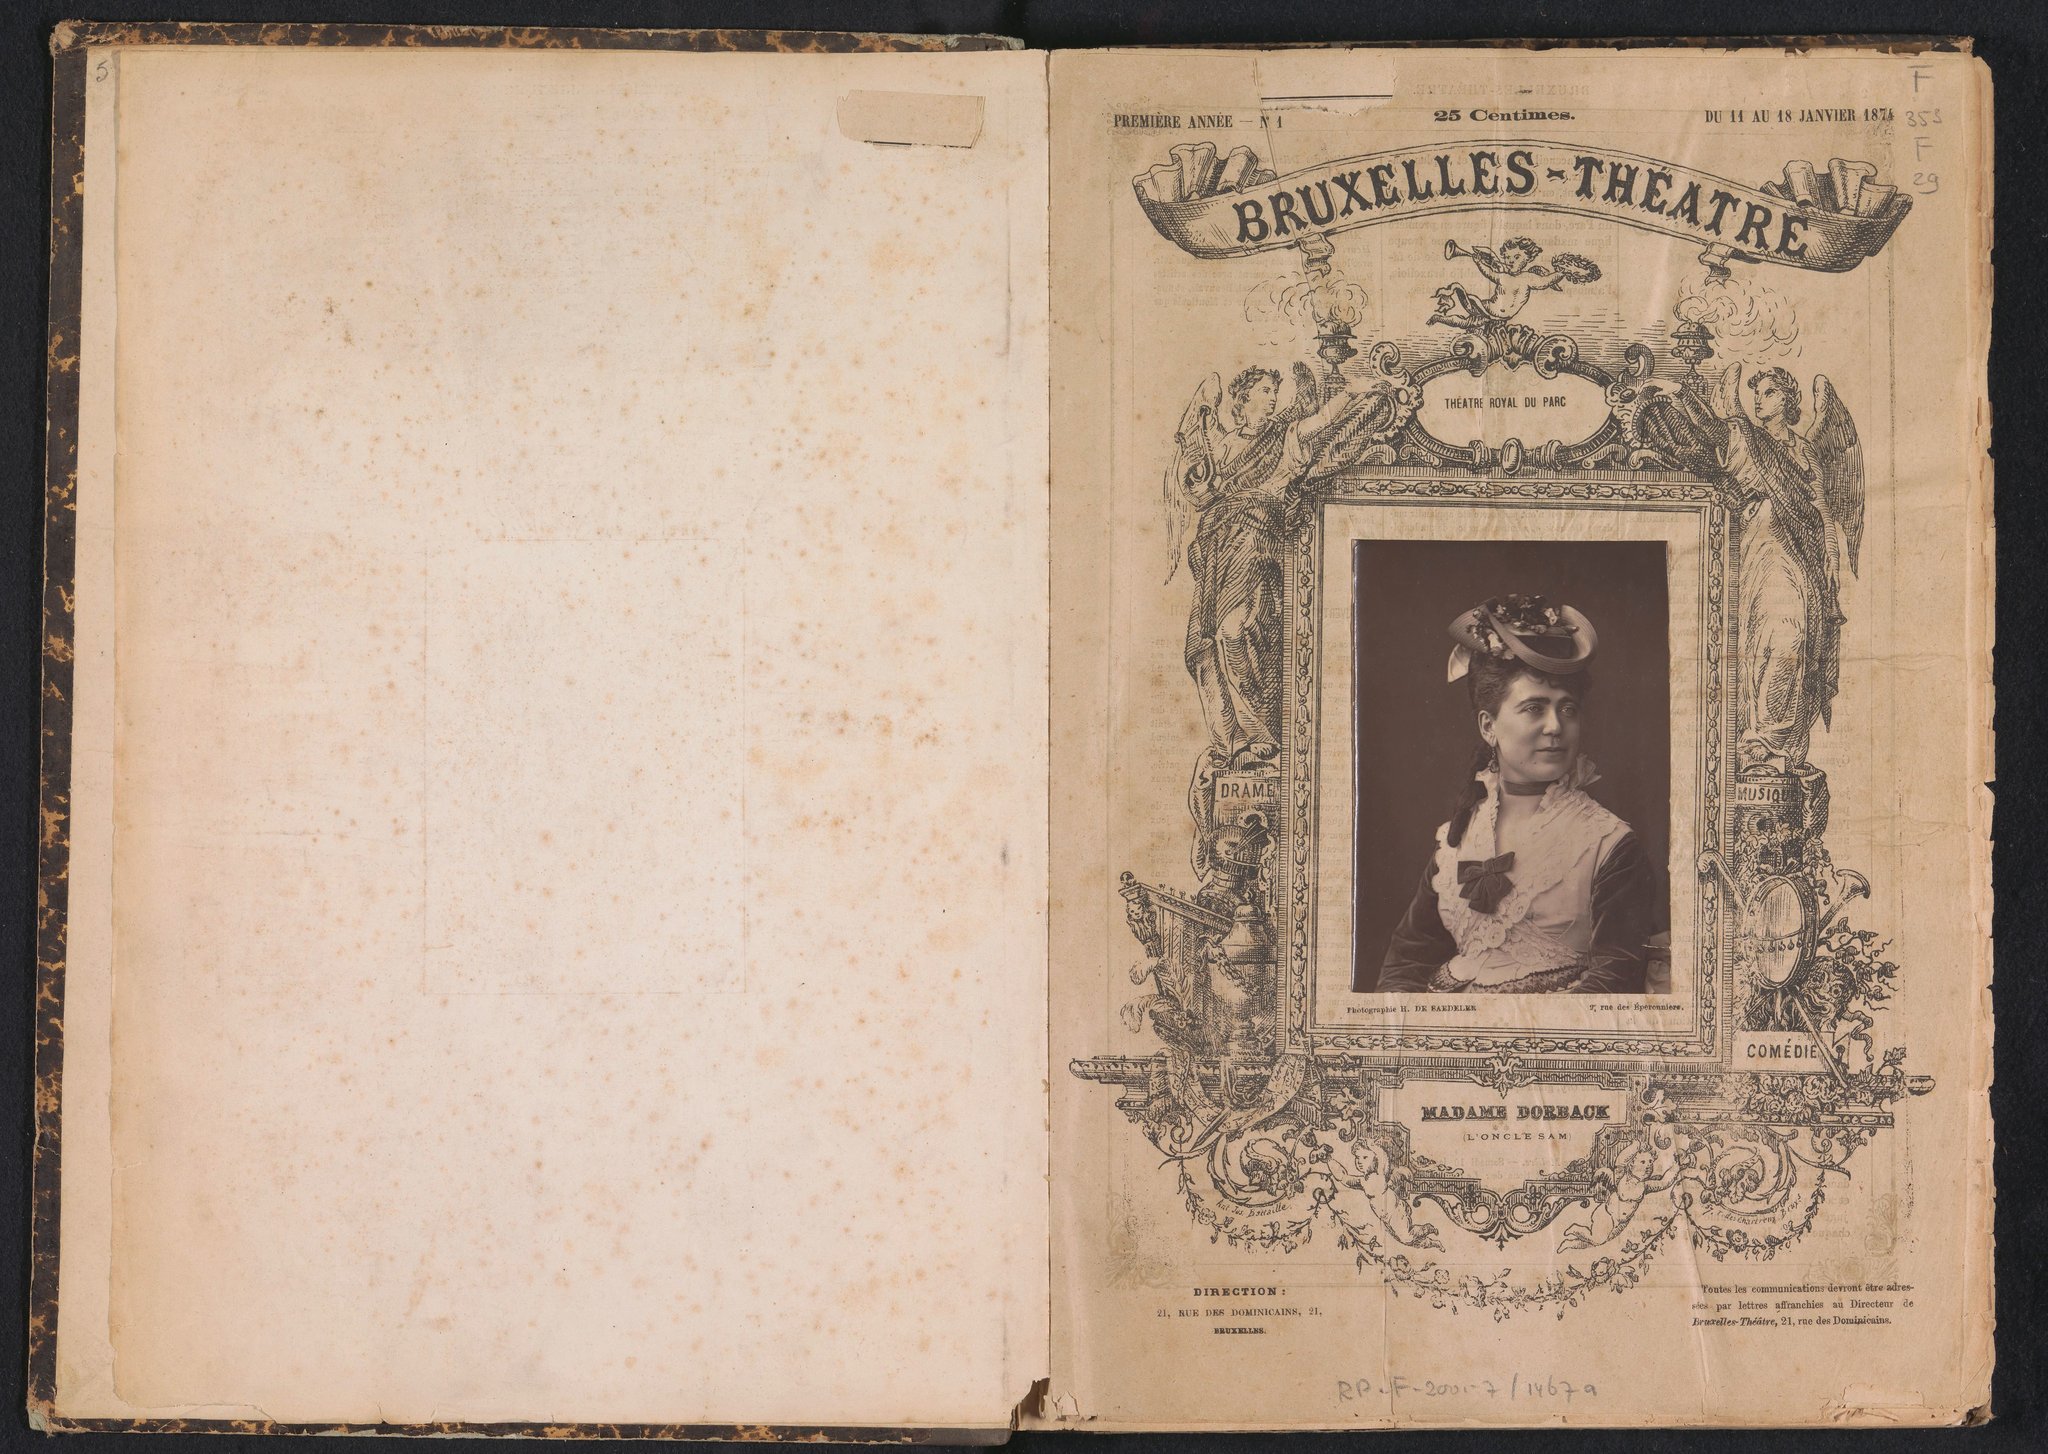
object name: book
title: Bruxelles théâtre 1874-1875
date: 1874-1875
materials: cardboard, paper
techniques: marbled paper, printing, woodburytype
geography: brussels